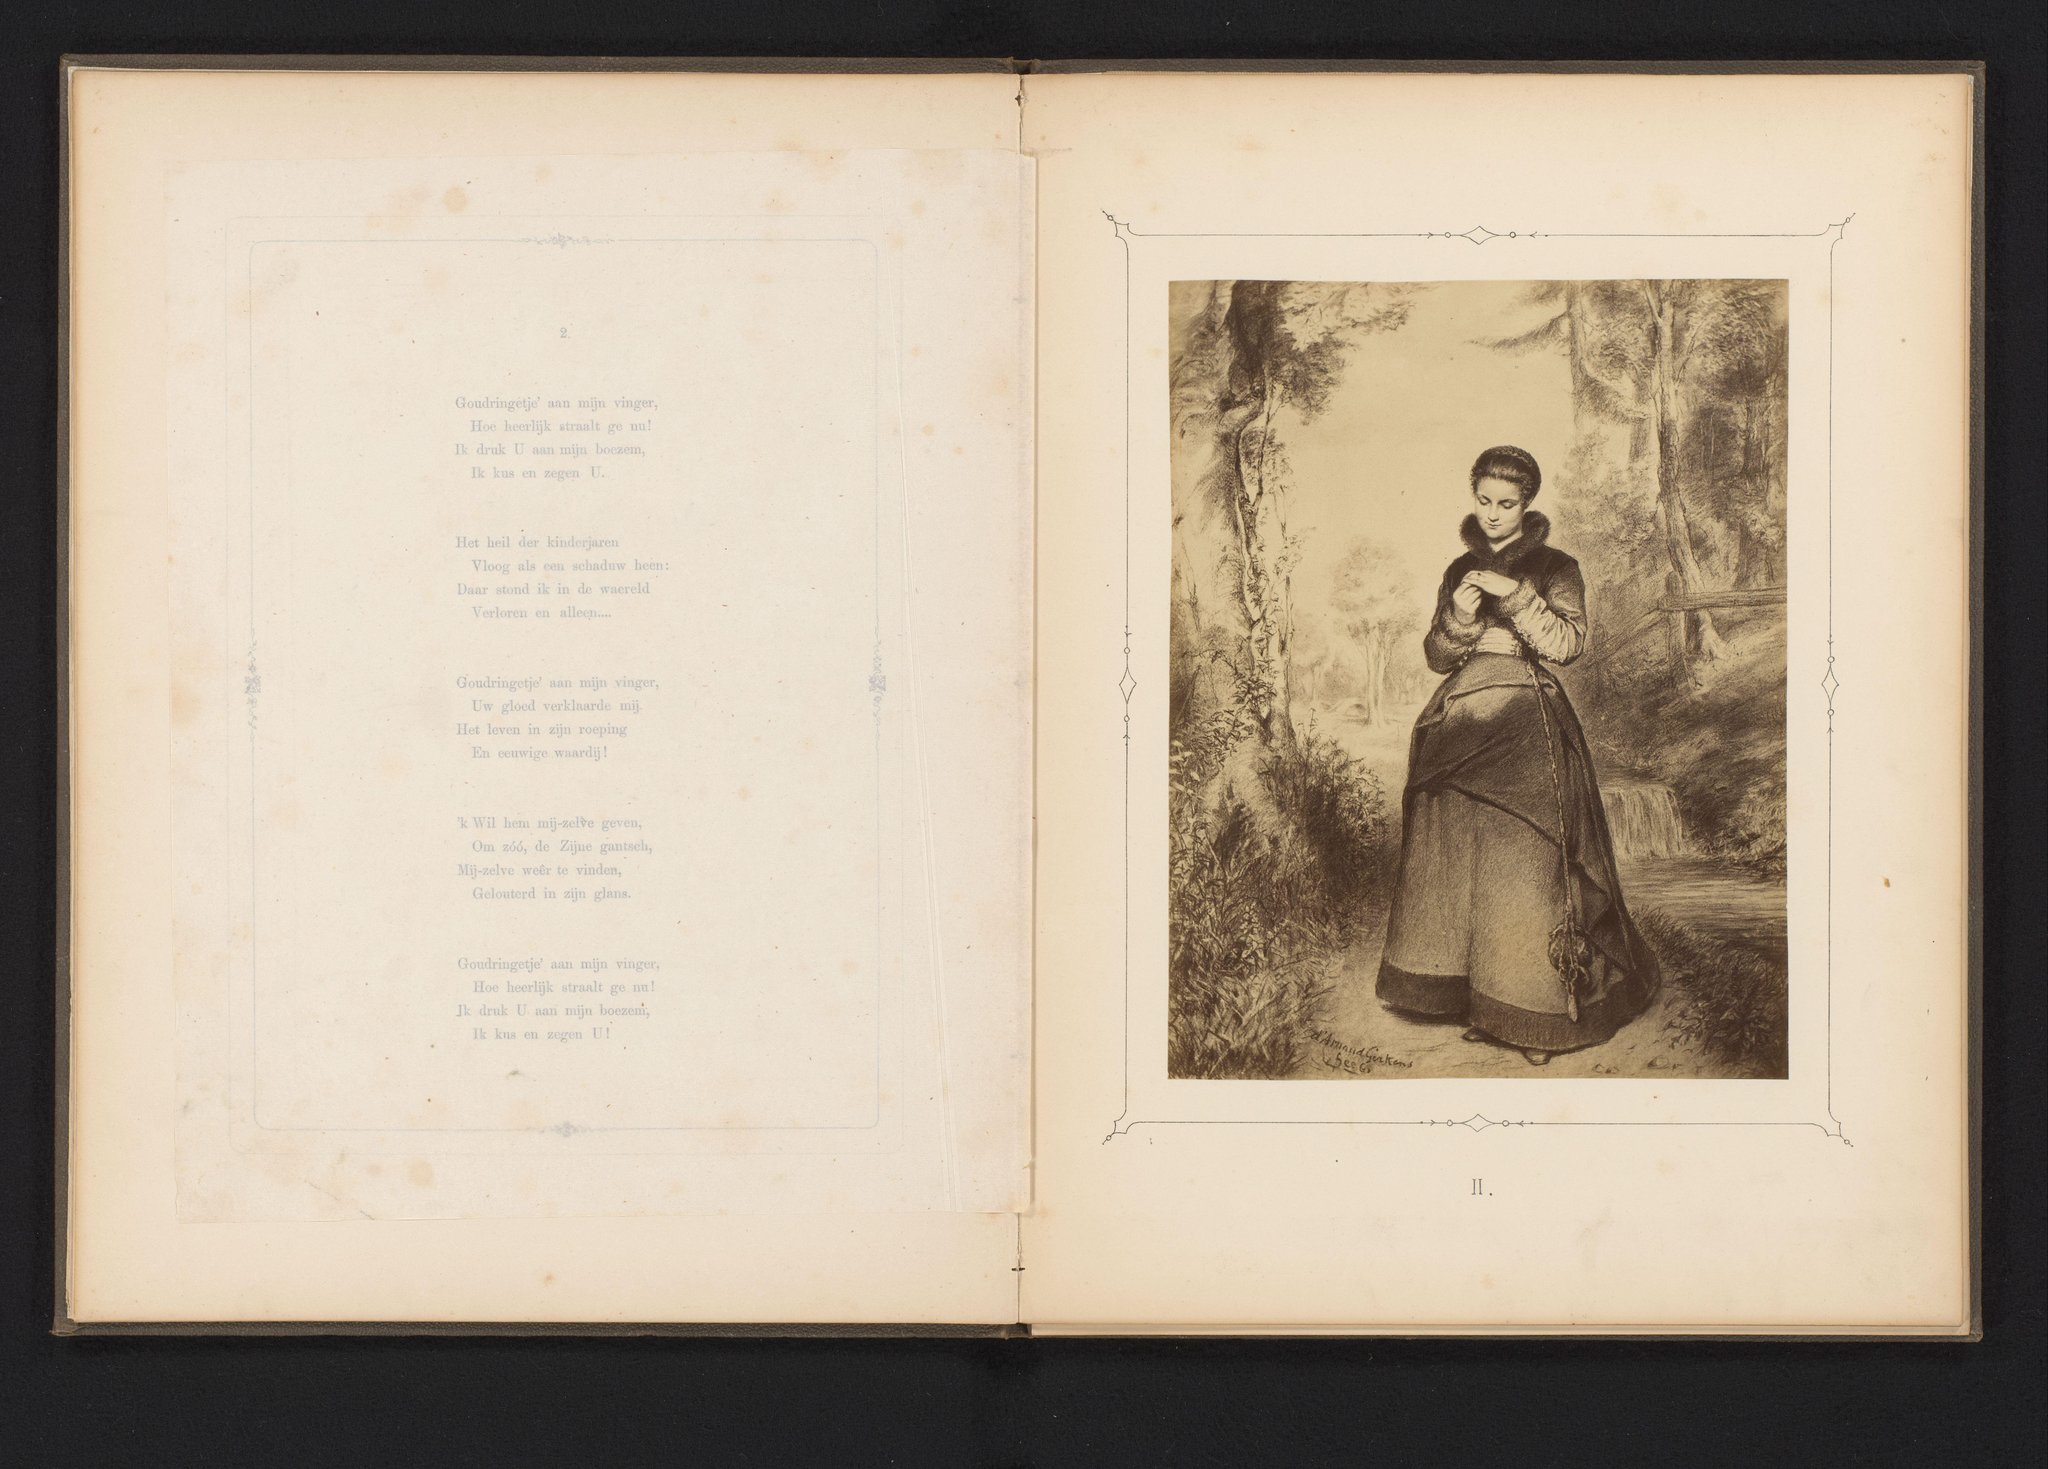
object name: reproduction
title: Fotoreproductie van een tekening van een jonge verloofde vrouw door Johannes Christiaan d'Arnaud Gerkens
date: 1858-1863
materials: paper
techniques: albumen print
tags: adolescent, young woman, maiden